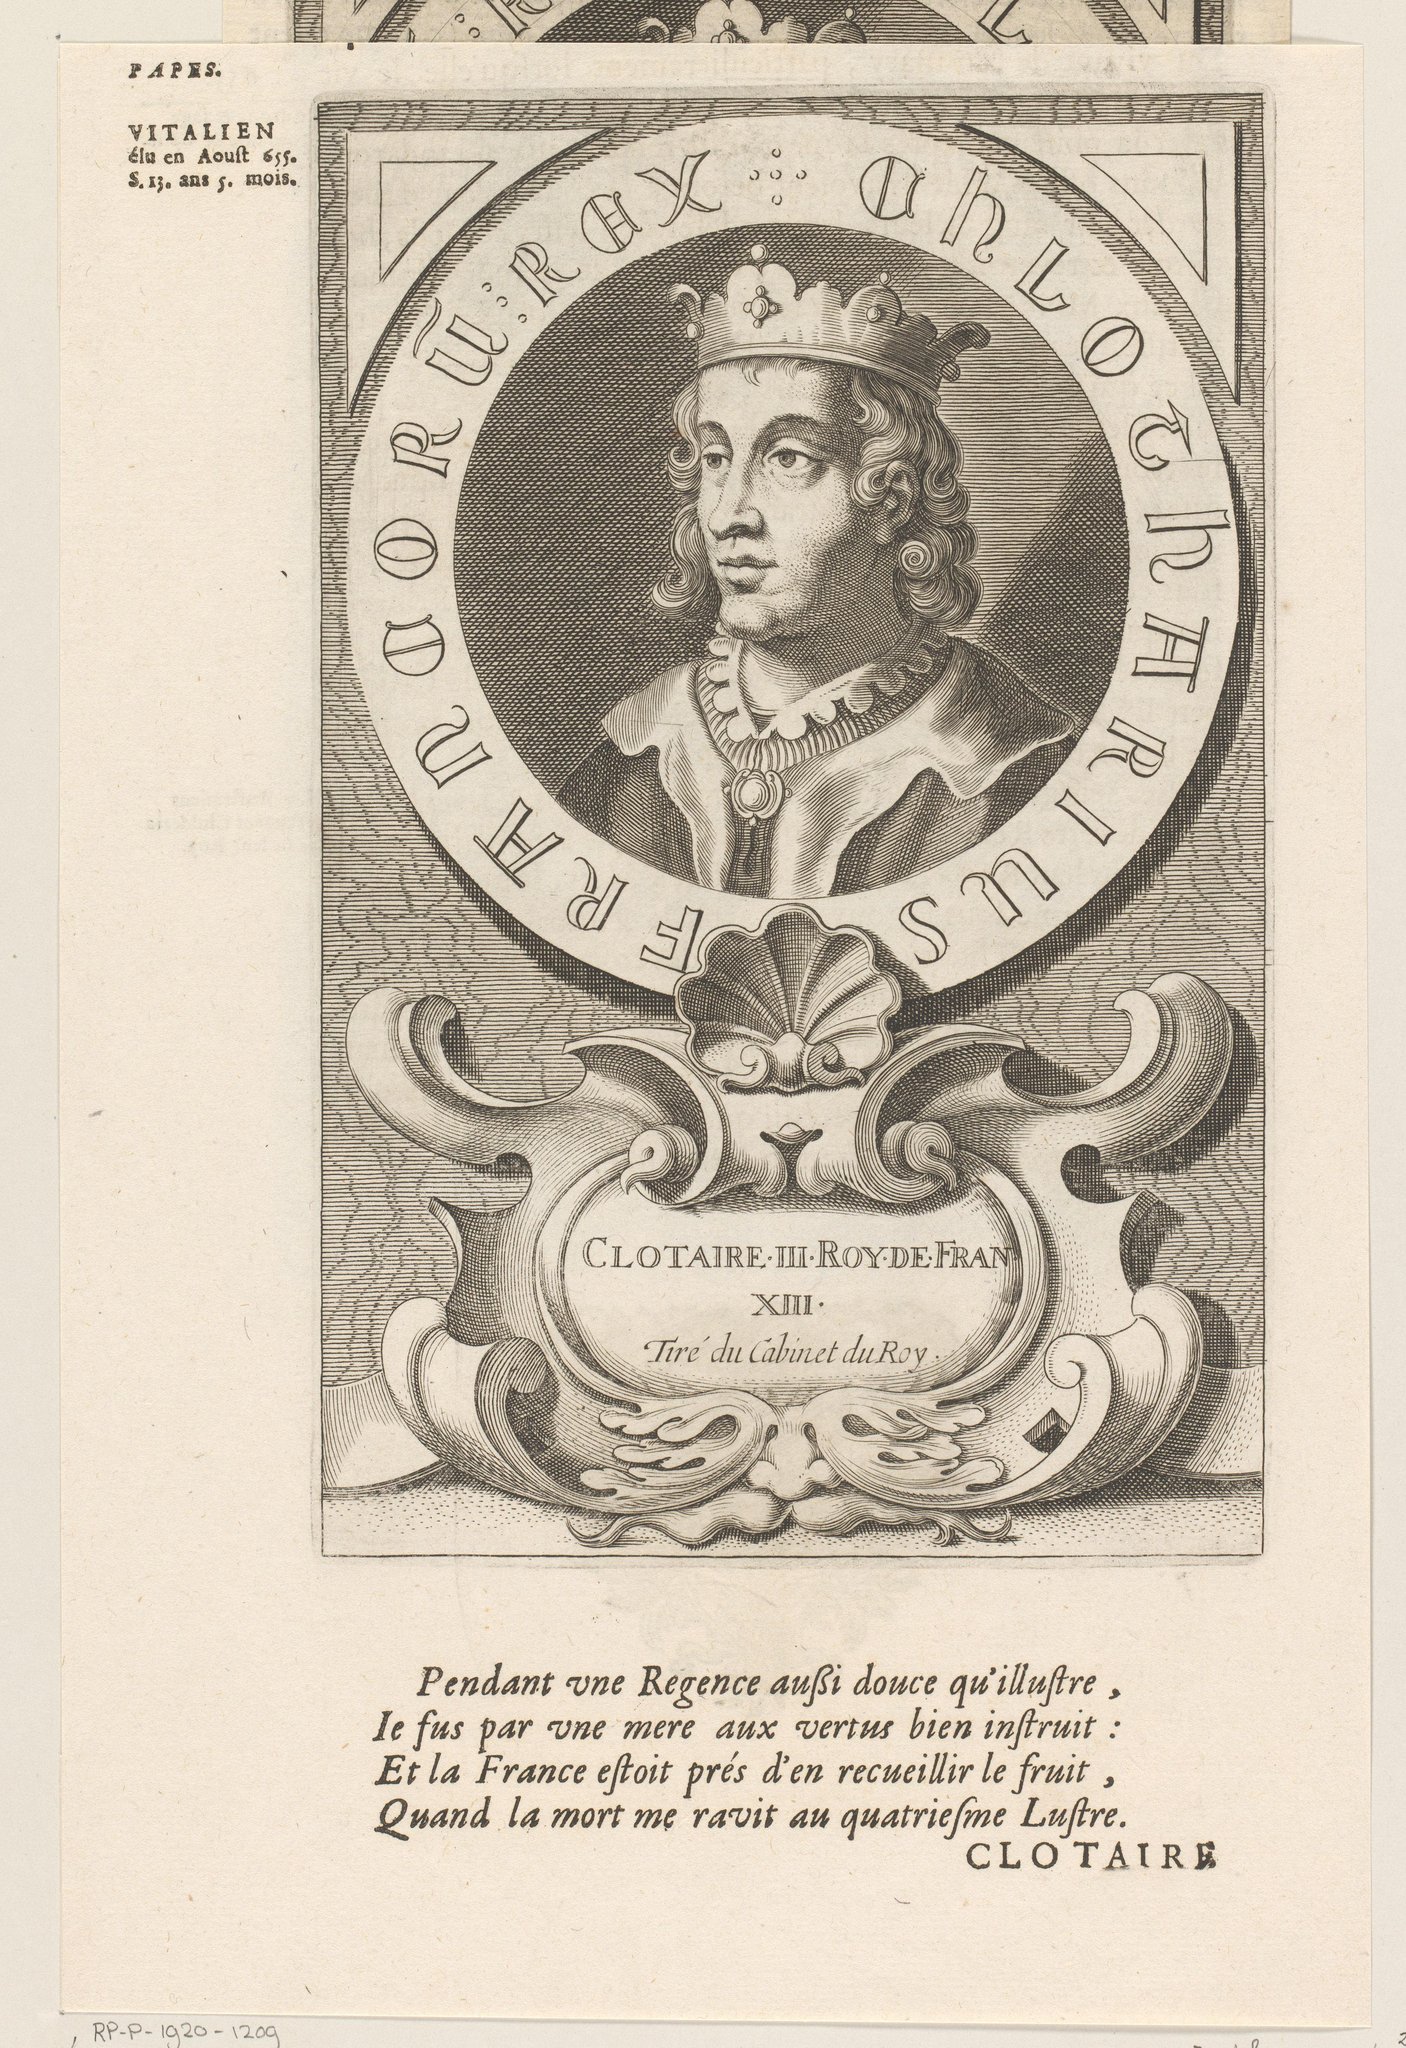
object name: print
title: Portret van Chlotharius III, koning van Neustrië en Bourgondië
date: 1635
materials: paper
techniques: engraving, letterpress printing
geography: paris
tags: historical persons, ruler, sovereign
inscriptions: collector's mark: Lugt 2228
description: Prent uit: Eudes de Mézeray, François. Histoire de France, depuis Faramond jusqu’au regne de Louis le Juste (...). 3 dln. Parijs: Denis Thierry, Jean Guignard en Claude Barbin, 1635, dl. 1. Prent waarschijnlijk voor het eerst verschenen in: Bie, Jacques de. Les vrais portraits des rois de France (...). Parijs: Jacques de Bie en Pierre Rocolet, 1634. Prent ook gebruikt in latere publicaties.